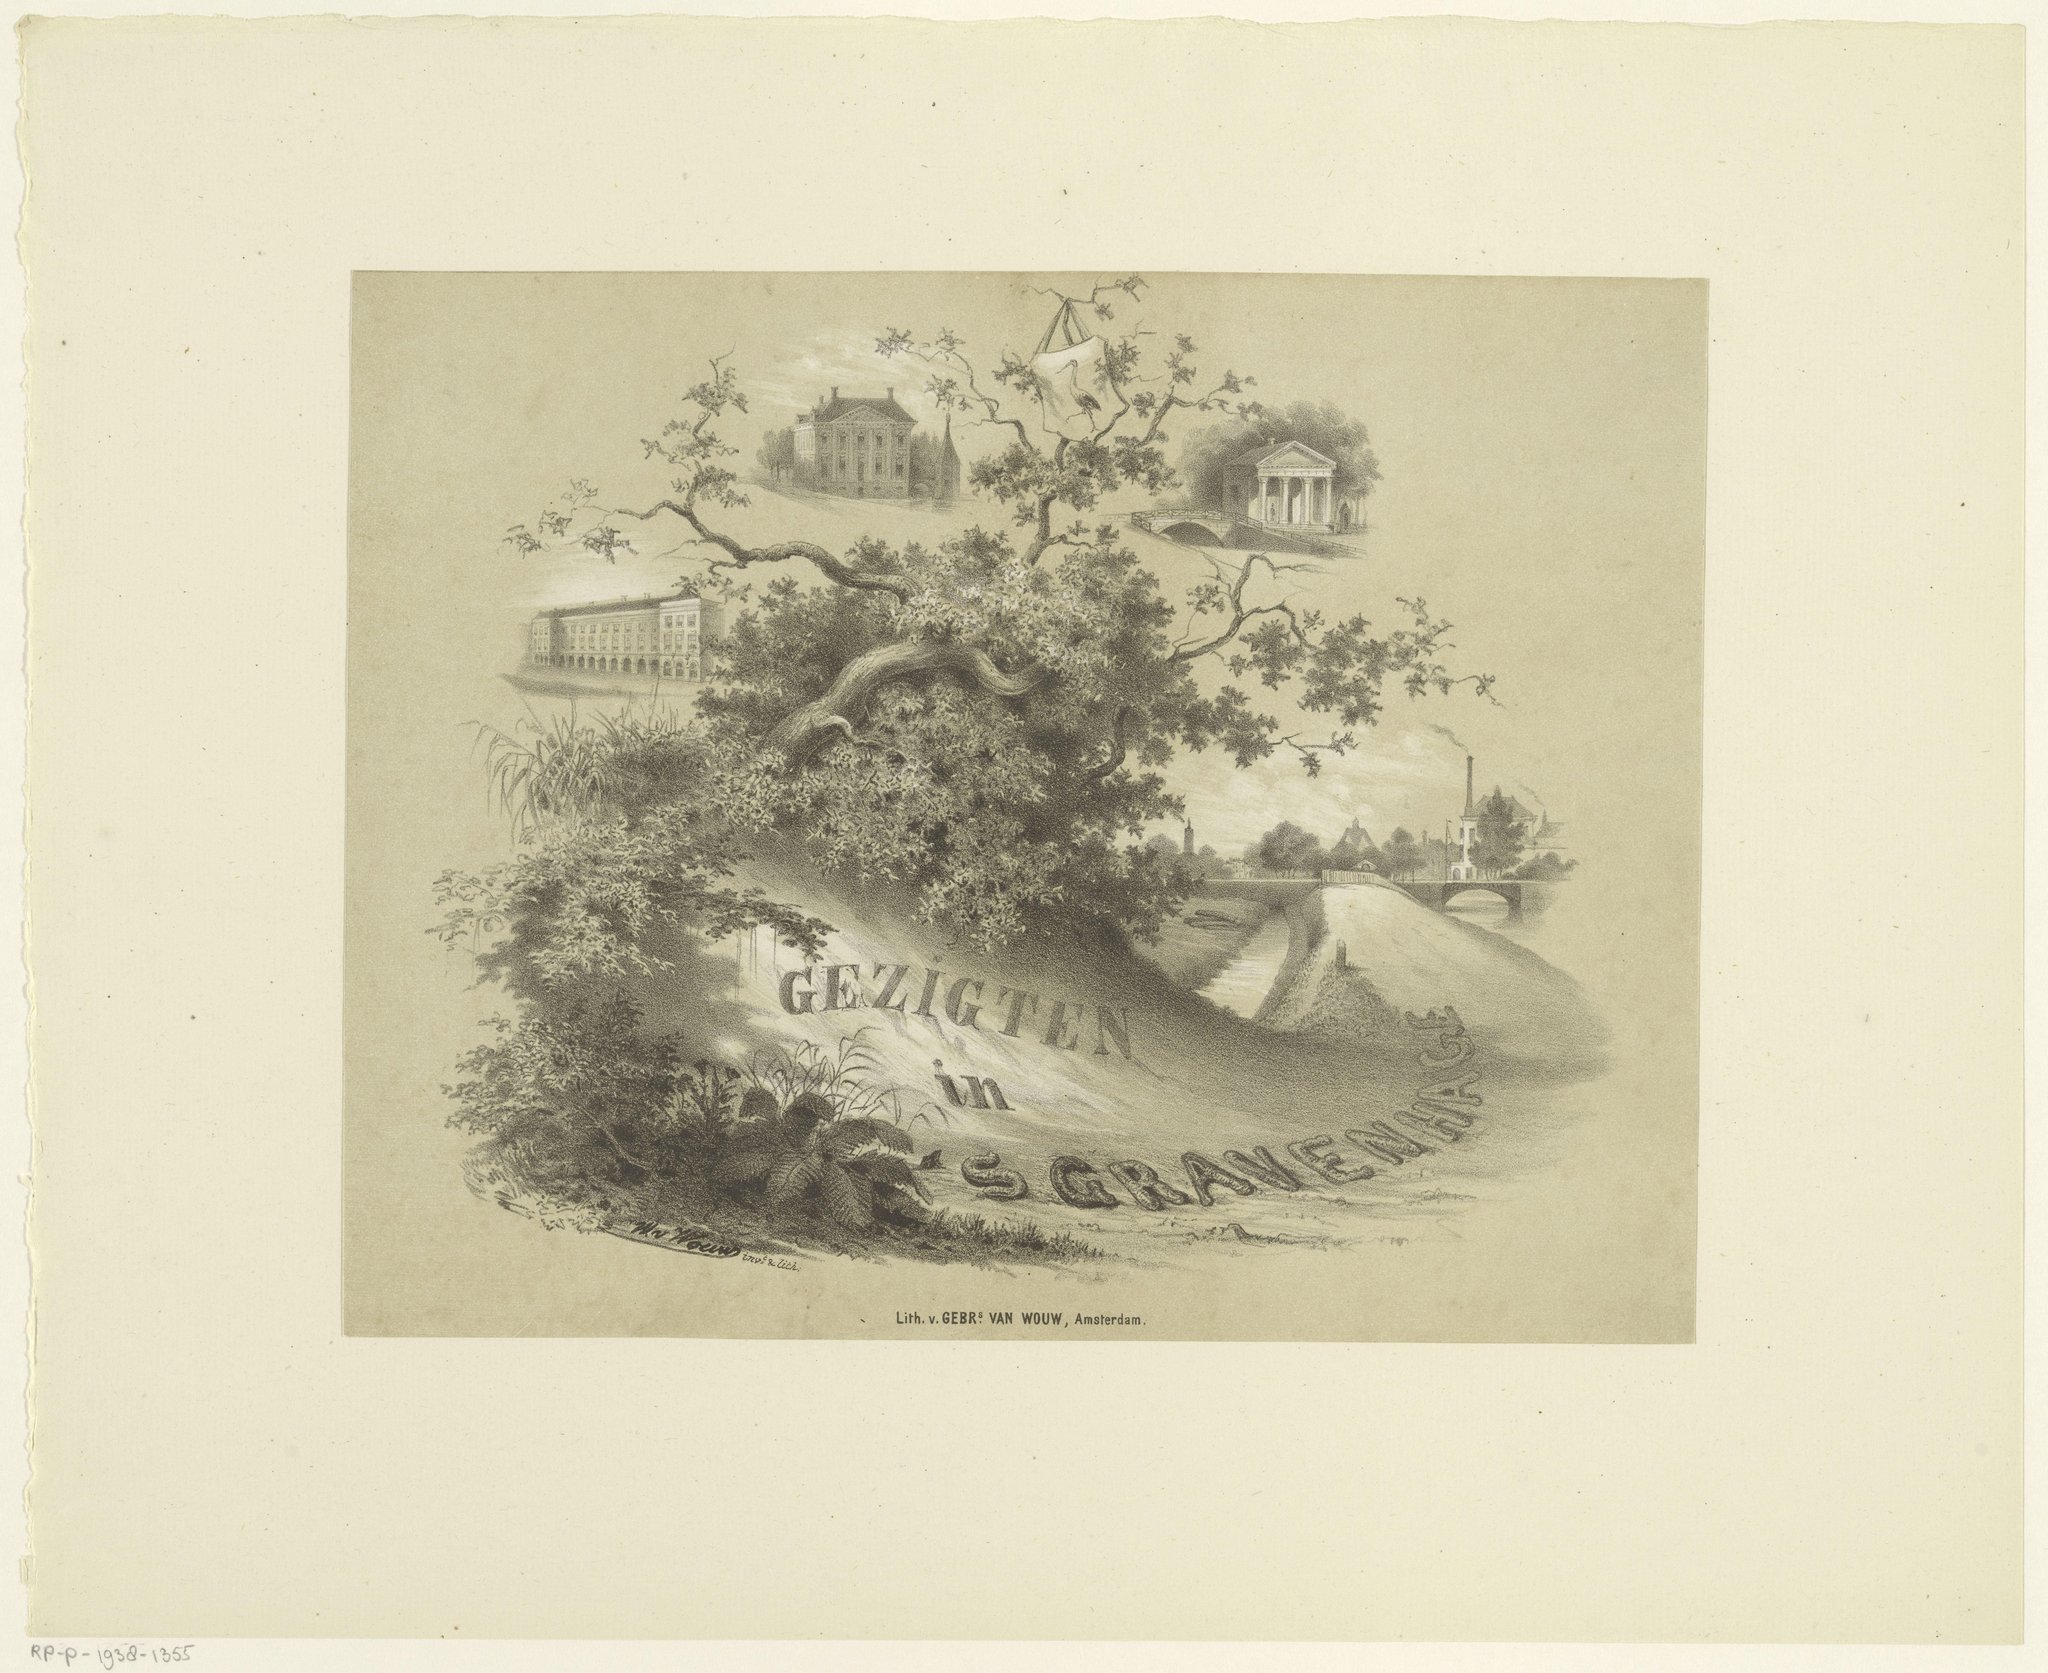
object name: print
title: Titelprent voor: Gezigten in 's-Gravenhage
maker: willem bastiaan van wouw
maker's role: print maker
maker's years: 1822-1878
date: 1844-1871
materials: paper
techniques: tone lithography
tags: forest, wood, forest path or lane, the hague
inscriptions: collector's mark: Lugt 2760, collector's mark: Lugt 2228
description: In het midden een bosrand die overgaat in een landweg. Aan het einde daarvan ligt Den Haag. In de takken hangt het wapen van Den Haag: een schild met een ooievaar met een paling in zijn bek. Daarboven drie gebouwen in Den Haag.